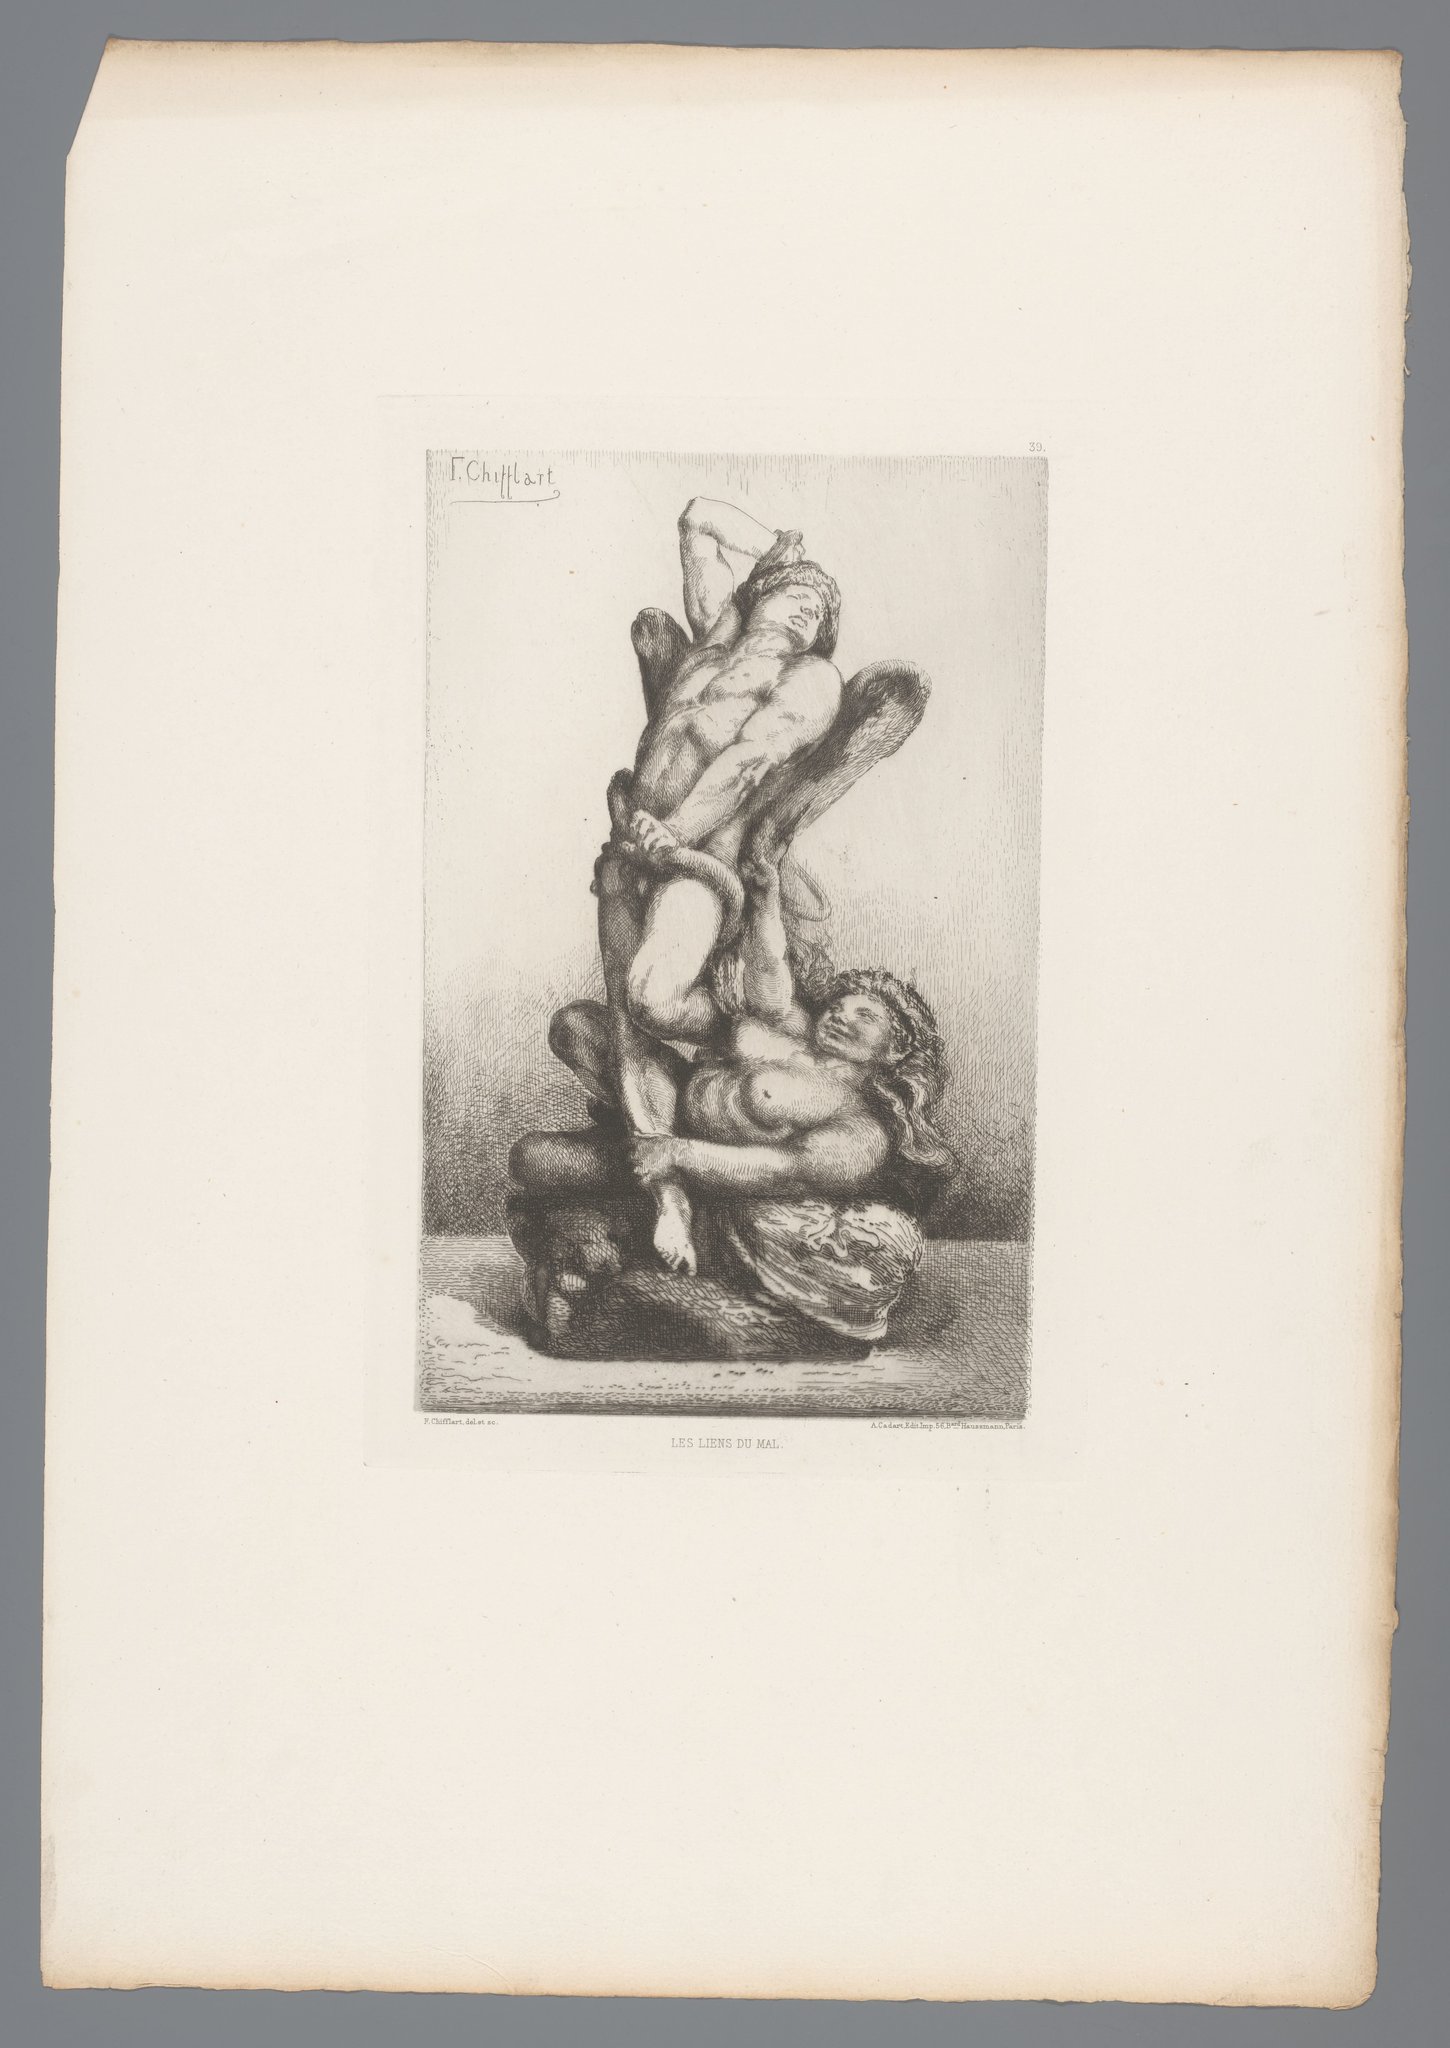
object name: print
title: Naakte man gevangen door slang en naakte vrouw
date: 1875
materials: paper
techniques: drypoint, etching, intaglio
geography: paris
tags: snakes, the (nude) human figure; 'corpo humano' (ripa)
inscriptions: collector's mark: Lugt 2760, collector's mark: Lugt 2228, collector's mark: ‘AFE v S’